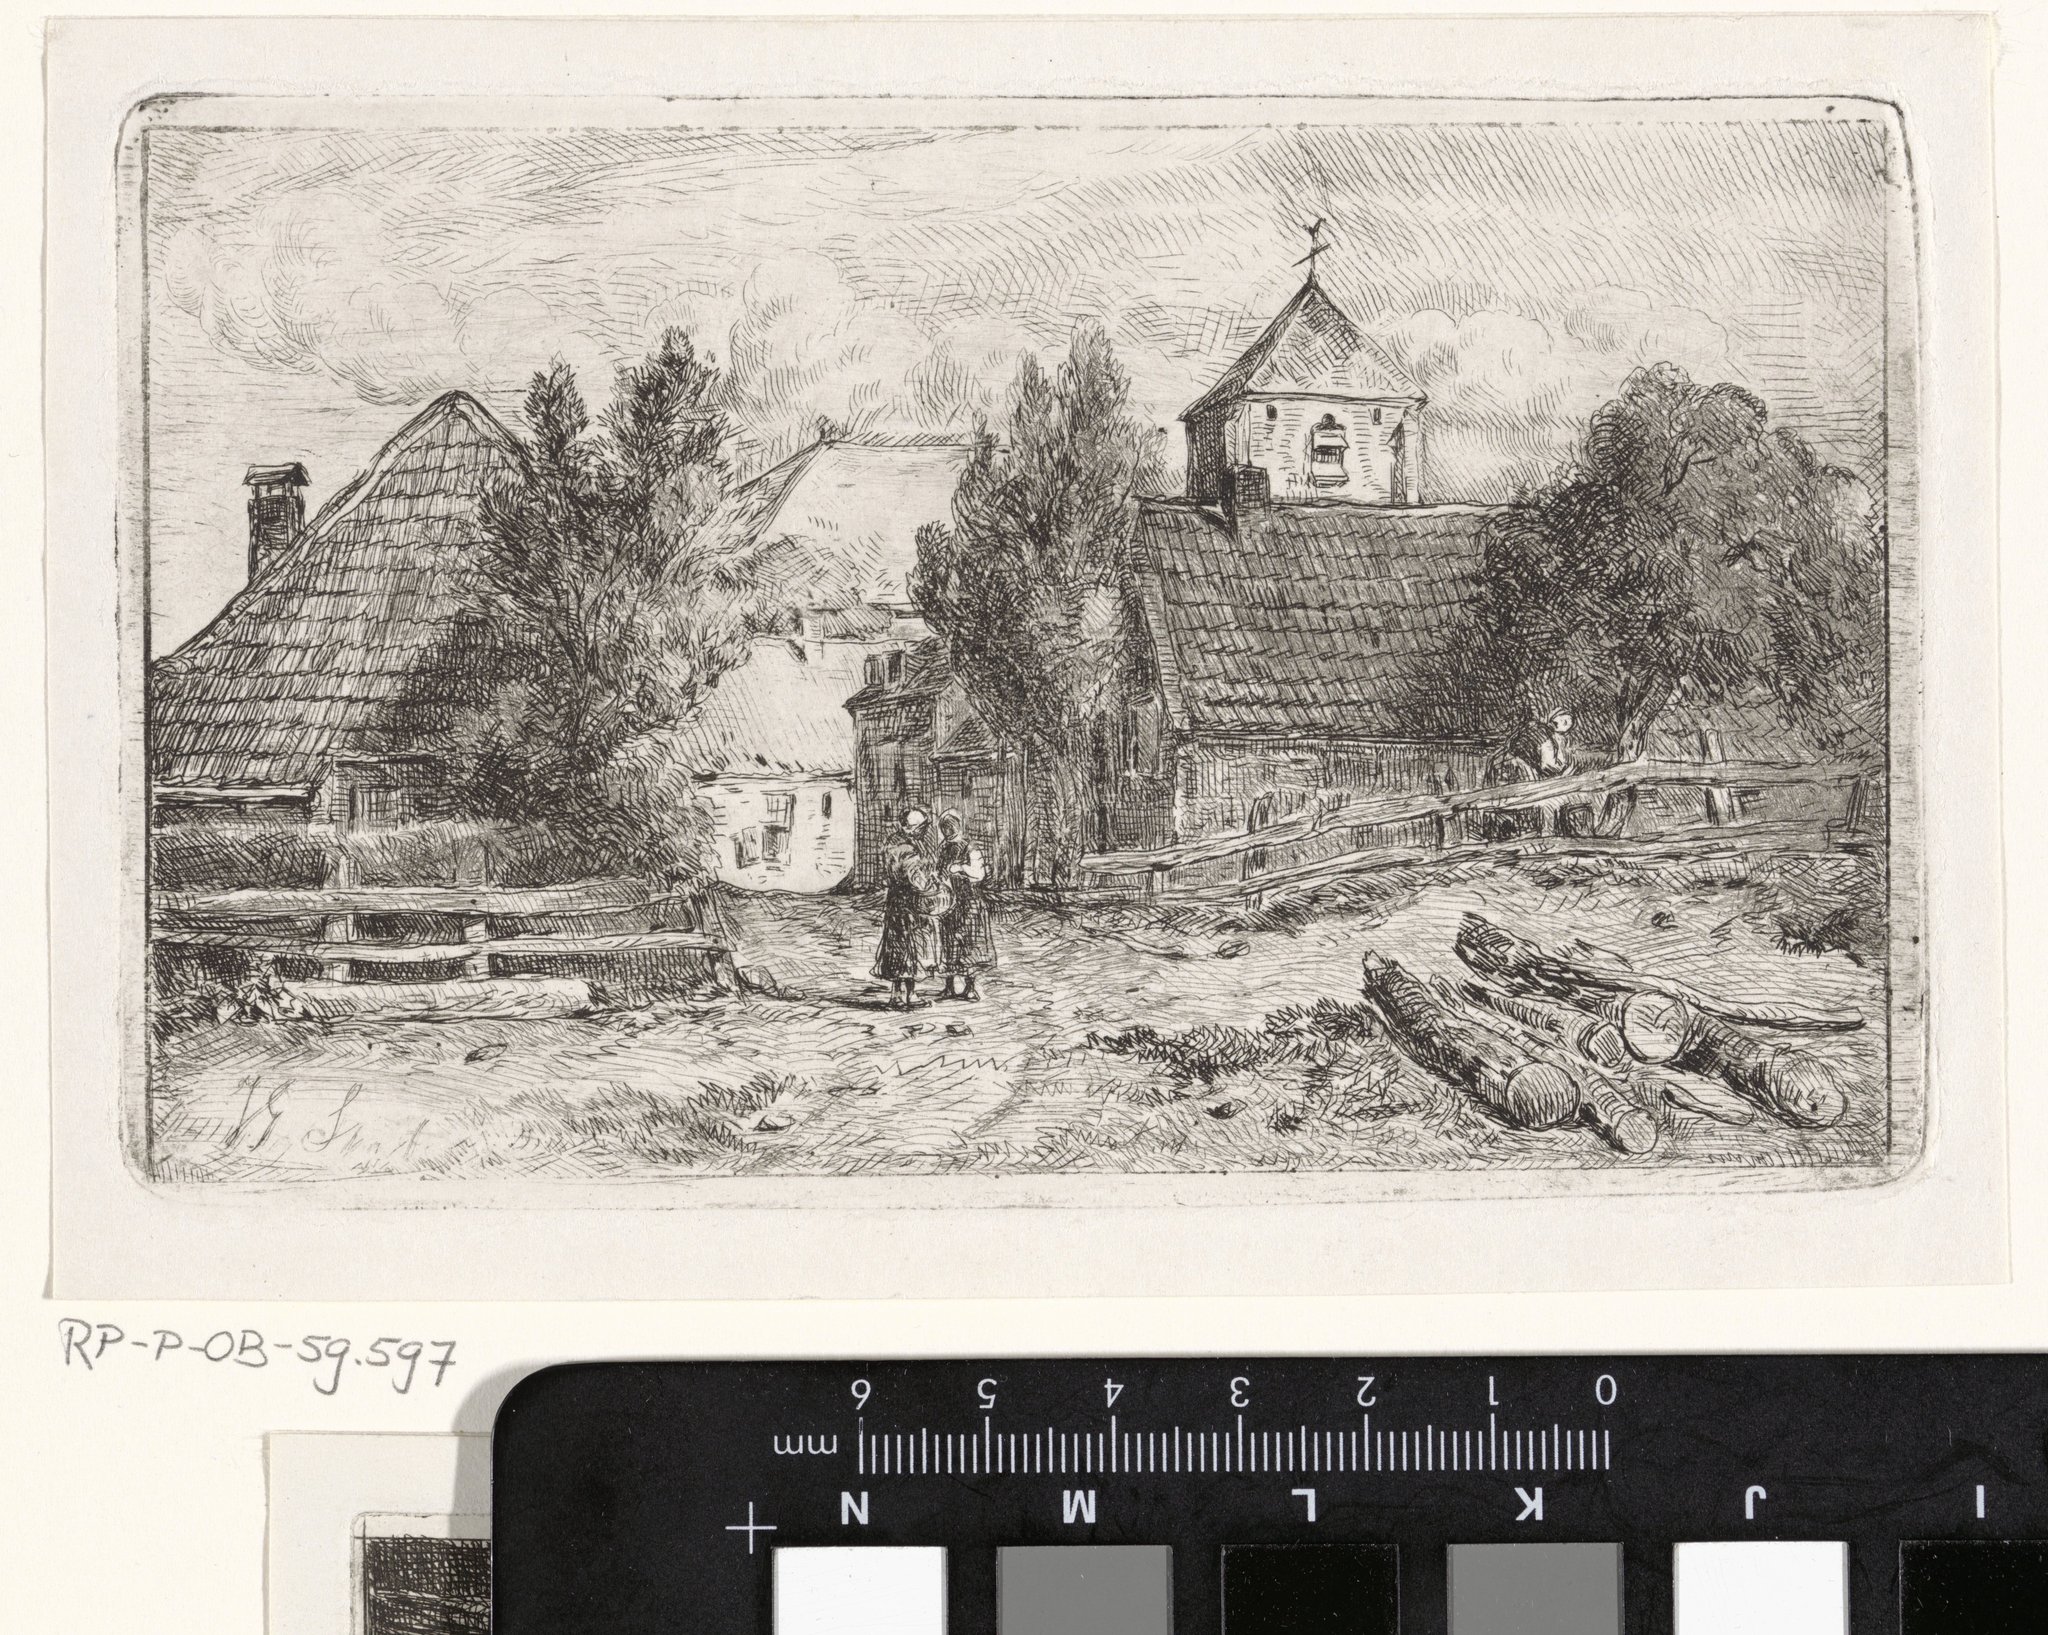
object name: print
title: Dorpsgezicht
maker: jan gerard smits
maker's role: draughtsman, print maker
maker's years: 1823-1910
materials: paper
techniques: etching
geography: the hague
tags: outskirts of village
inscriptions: collector's mark: Lugt 2228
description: Op een landweg naar een dorpje met links een boerderij en rechts een kerkje staan twee vrouwen te praten. Op de voorgrond liggen enkele boomstammen.